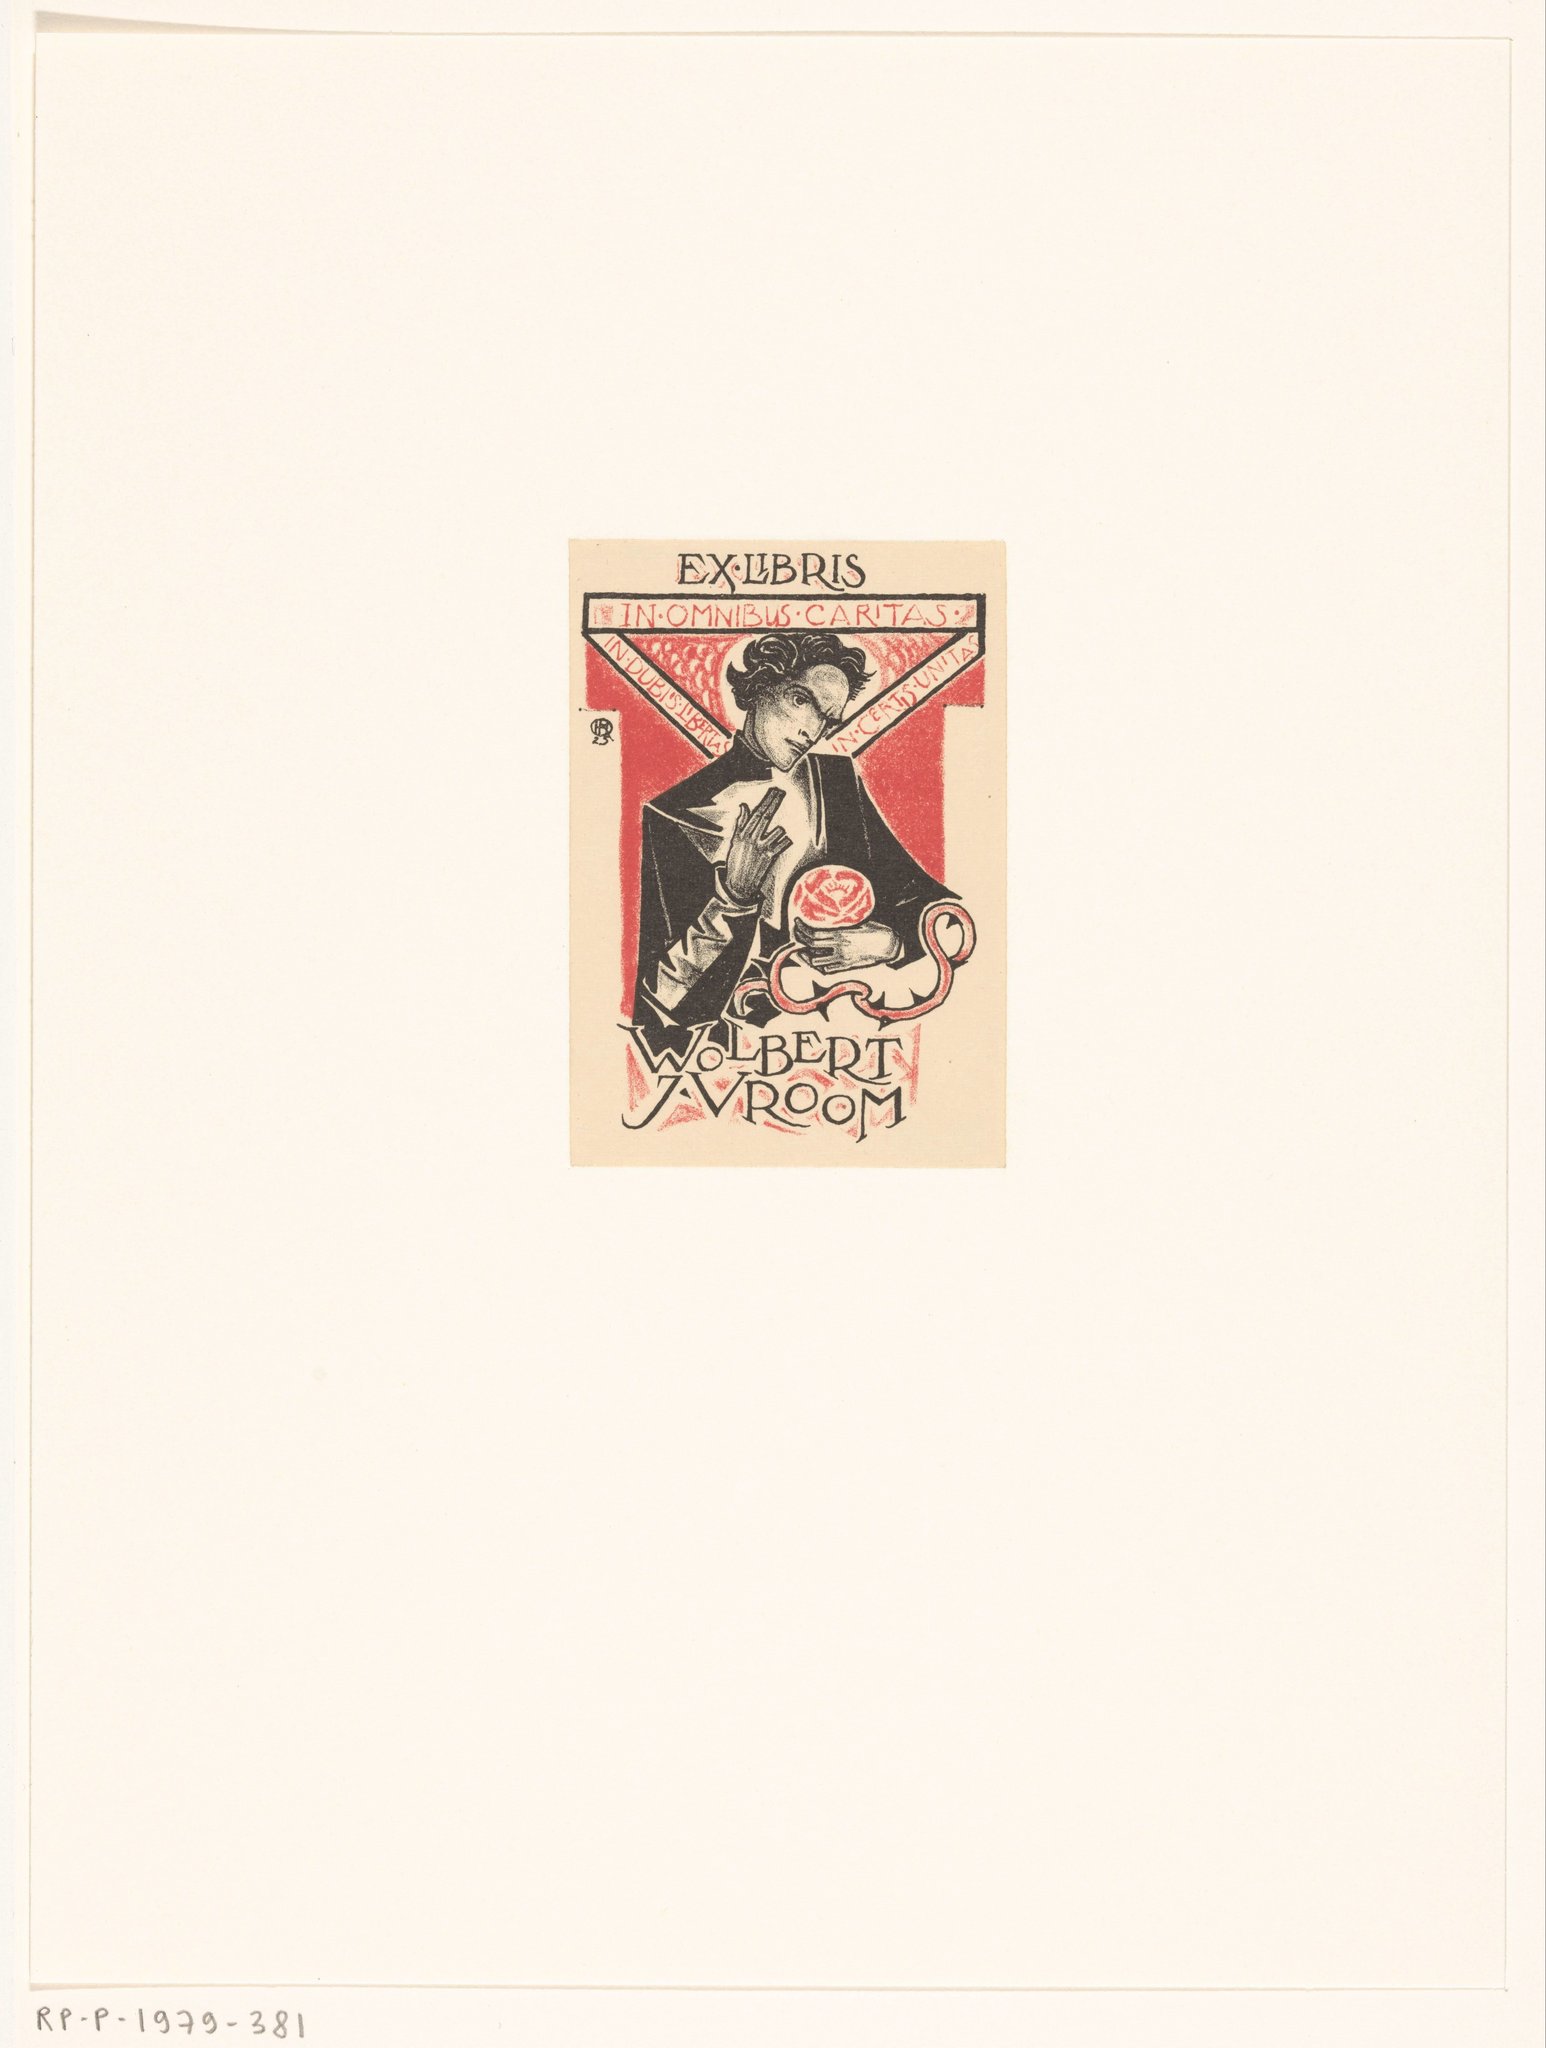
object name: print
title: Ex libris Wolbert J. Vroom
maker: richard nicolaüs roland holst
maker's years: 1868-1938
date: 1925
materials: paper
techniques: lithograph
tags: flowers: rose, organization, functionaries and dignitaries in roman catholic church; clergy in general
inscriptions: collector's mark: Lugt 2228